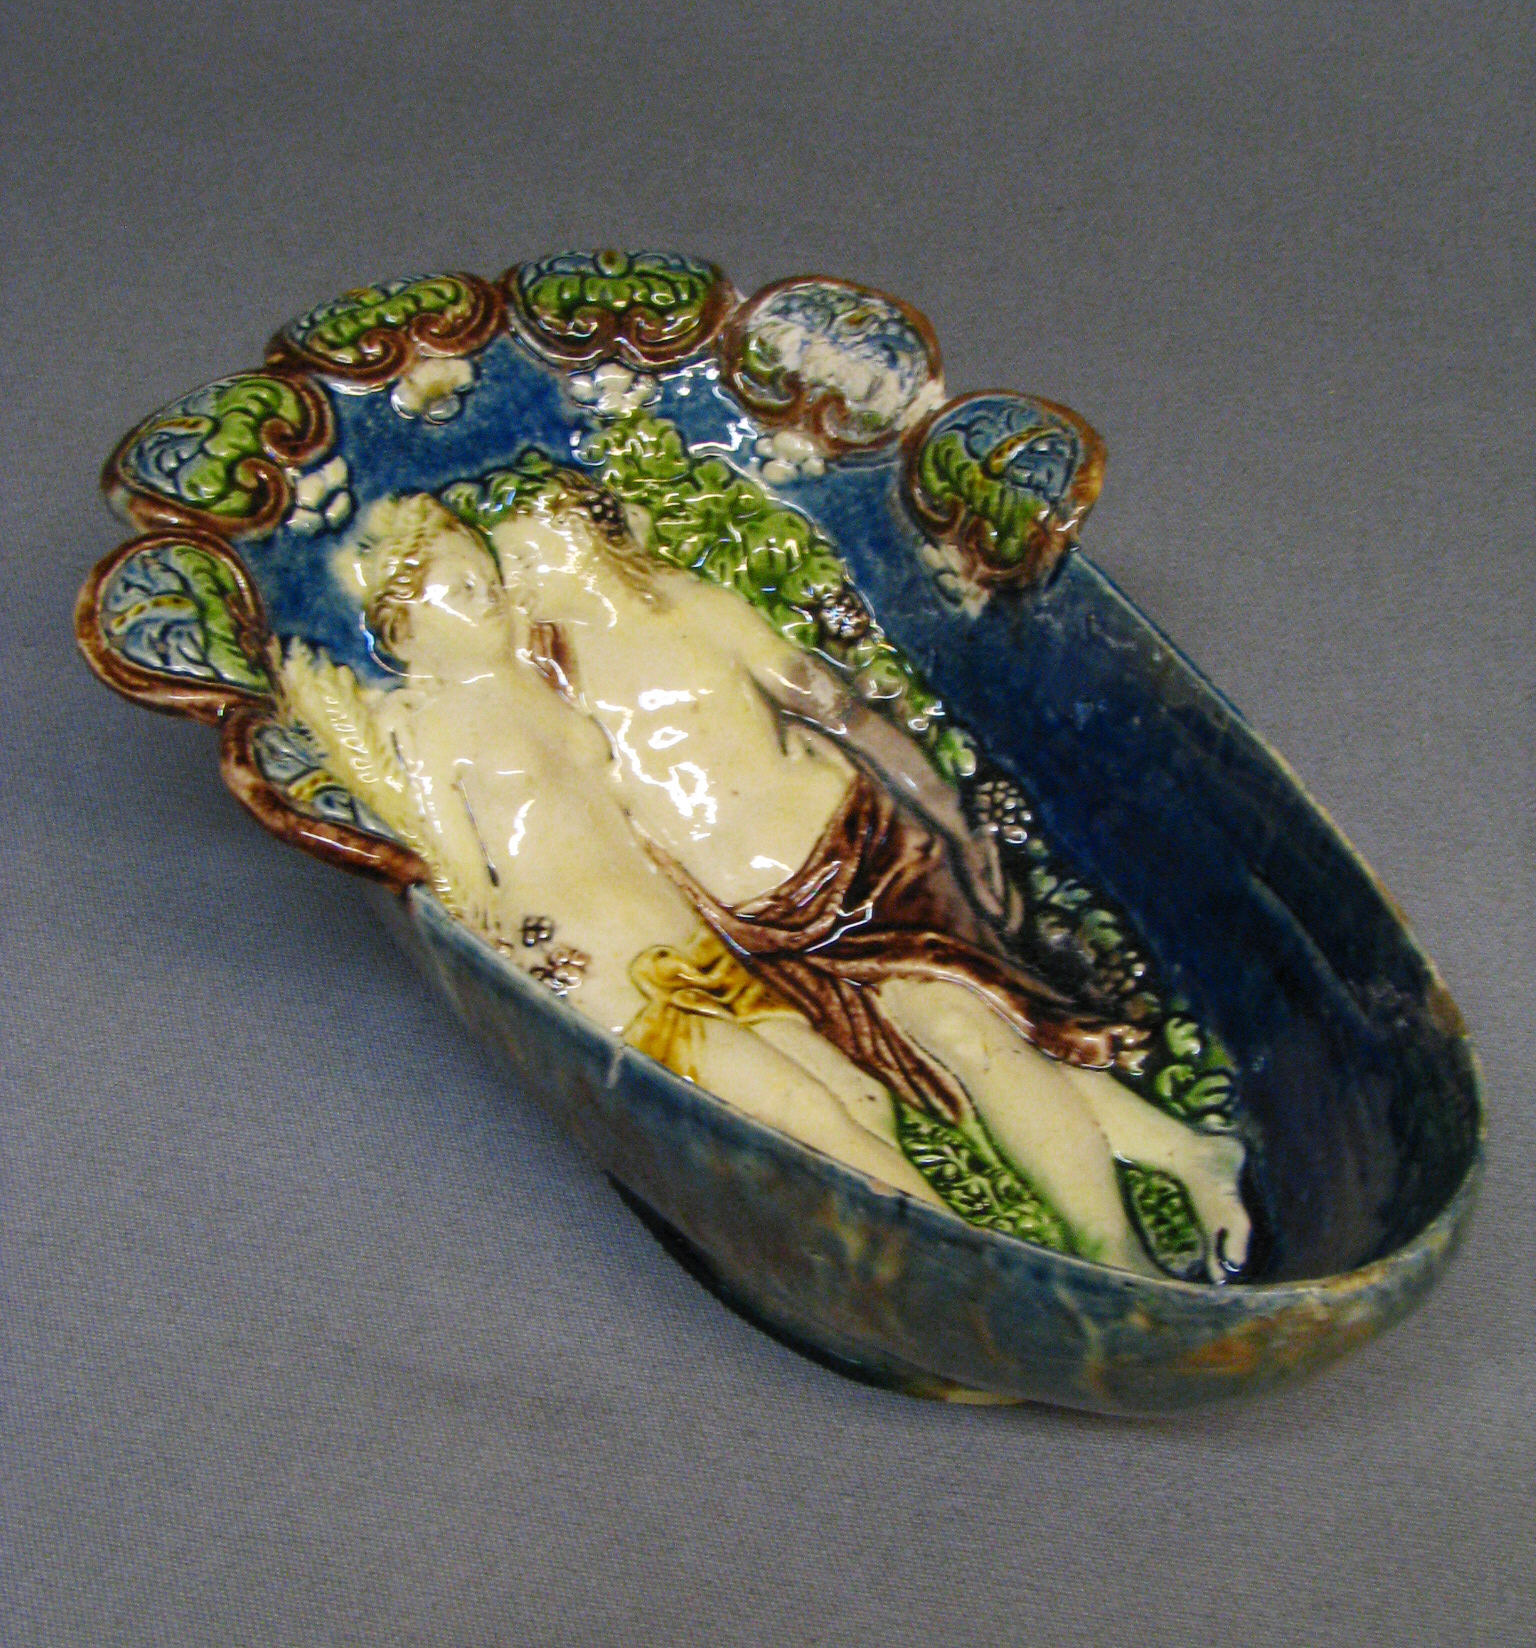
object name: gondola cup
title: Gondola cup (Coupe gondole) with Venus as Summer and Adonis as Autumn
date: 1601-1633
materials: earthenware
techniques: glazing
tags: adonis,venus